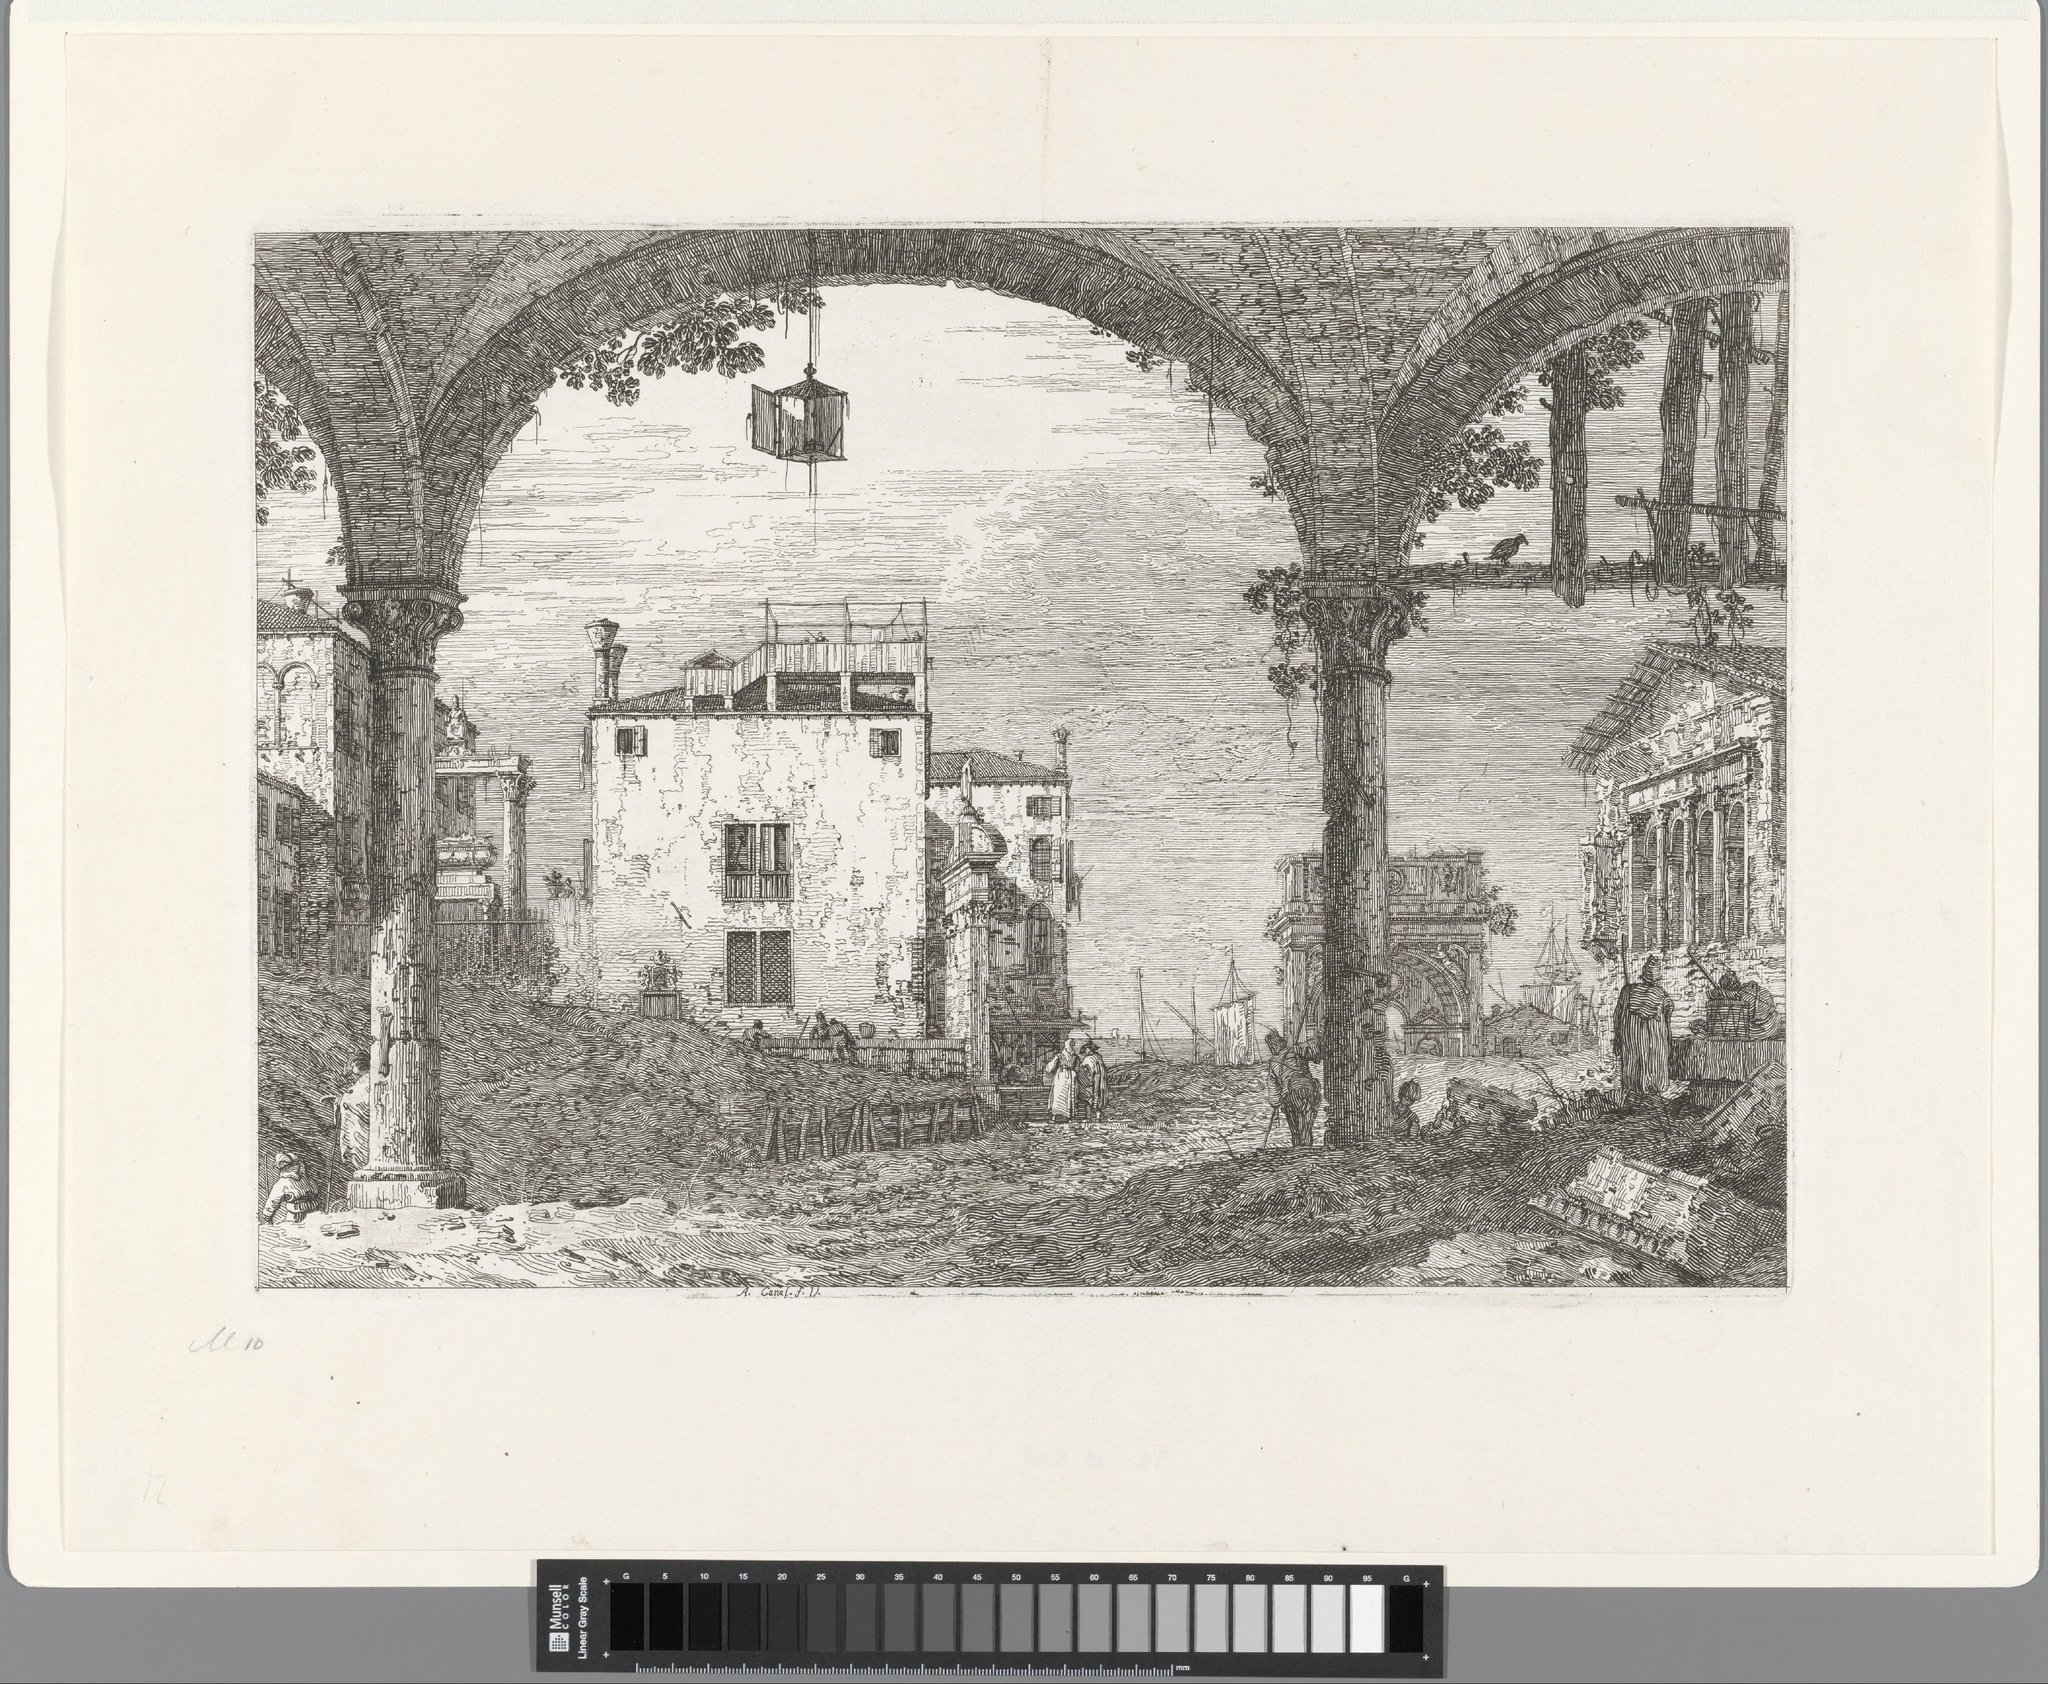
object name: print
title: Vedute altre prese da i Luoghi altre ideate da Antonio Canal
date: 1707-1768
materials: paper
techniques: etching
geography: venice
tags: ruin of a building ~ architecture, landscape with ruins, gallery (spacious corridor), lantern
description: Gezicht vanuit een gallerij waar een lantaarn aan het plafond hangt. Door de bogen van de gallerij zijn verschillende gebouwen en ruïnes, waaronder een triomfboog, te zien. Op de achtergrond liggen zeilschepen in een haven.